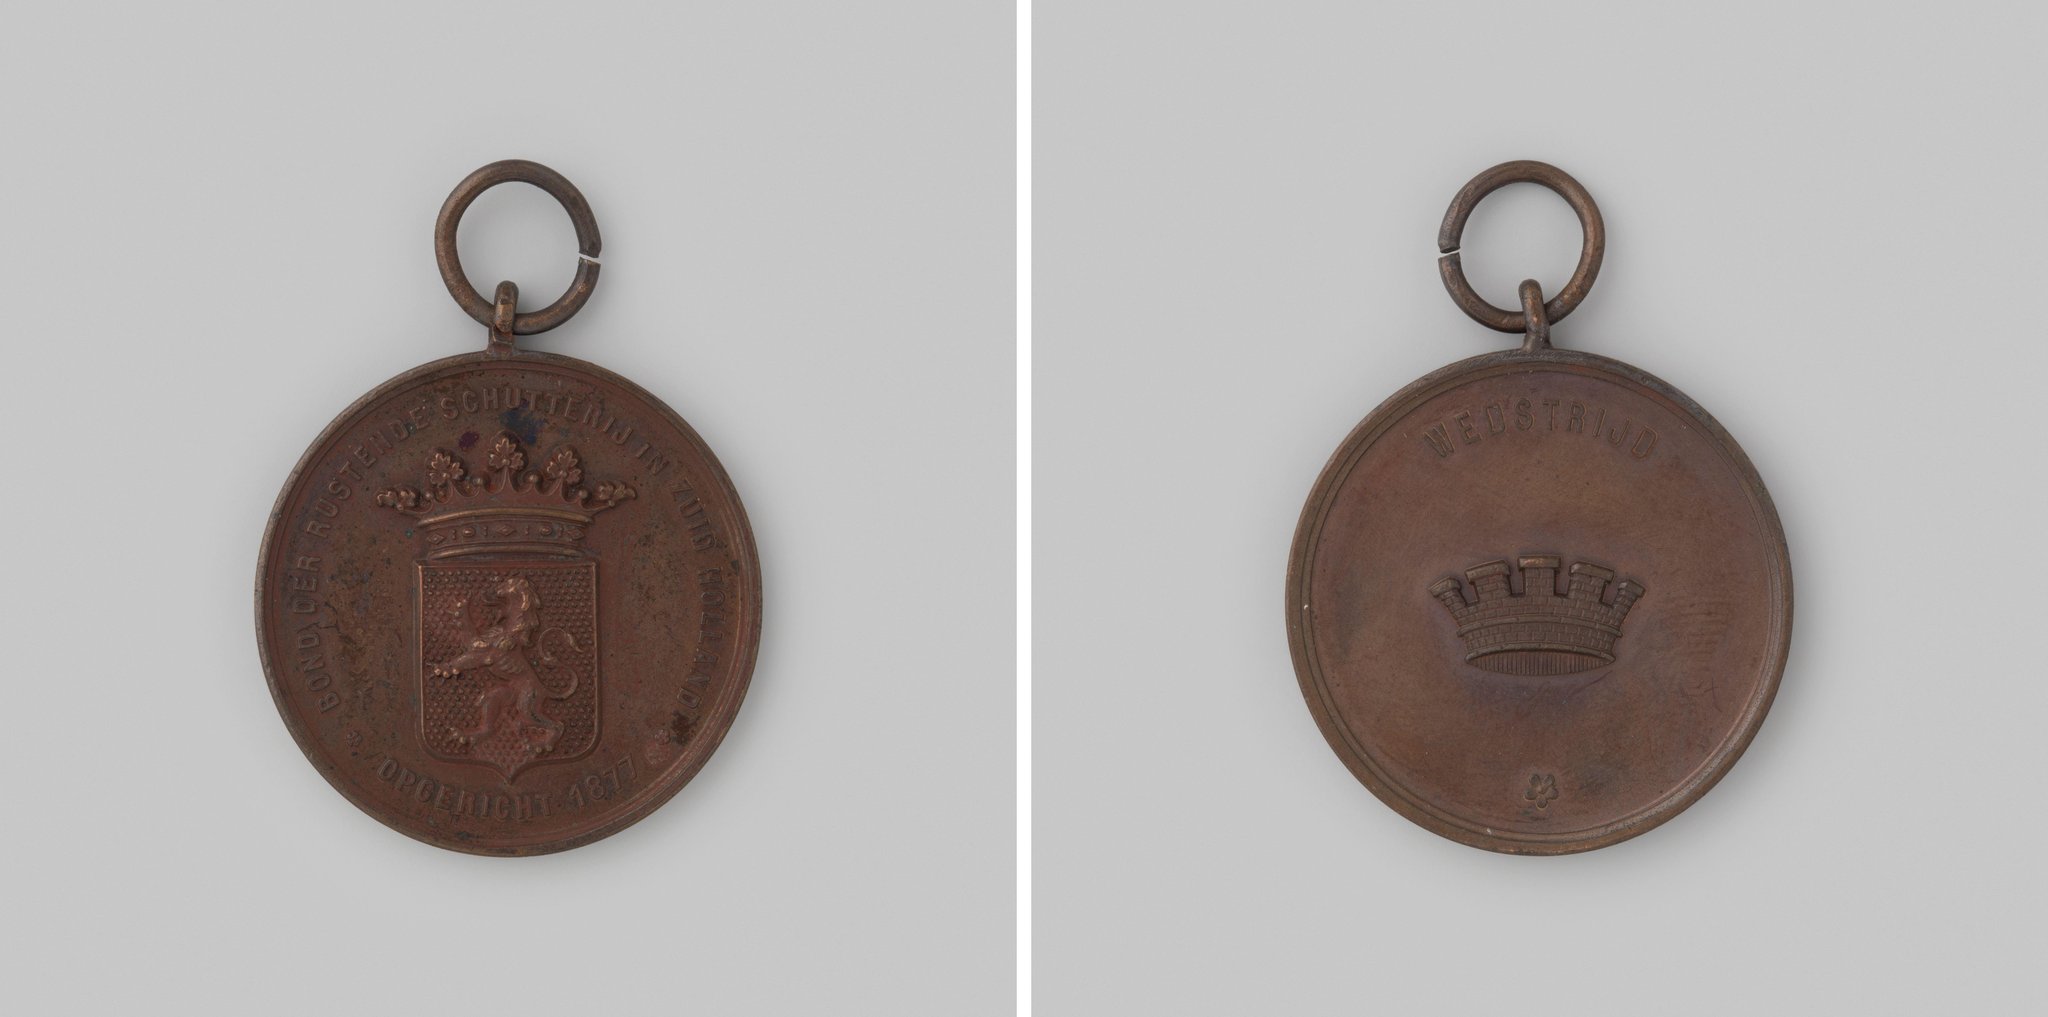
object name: medal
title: Prijspenning van de Bond der Rustende Schutterij in Zuid-Holland, behaald door het regiment schutterij te Amsterdam in 1885, vierde prijs voor Individueel-vuur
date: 1885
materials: bronze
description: Bronzen draagpenning met oog en ring. Voorzijde: Provinciewapen. Omschrift: BOND DER RUSTENDE SCHUTTERIJ IN ZUID-HOLLAND, OPGERICHT 1877. Keerzijde: muurkroontje, waarboven opschrift WEDSTRIJD en waaronder een bloempje van vijf bladeren.